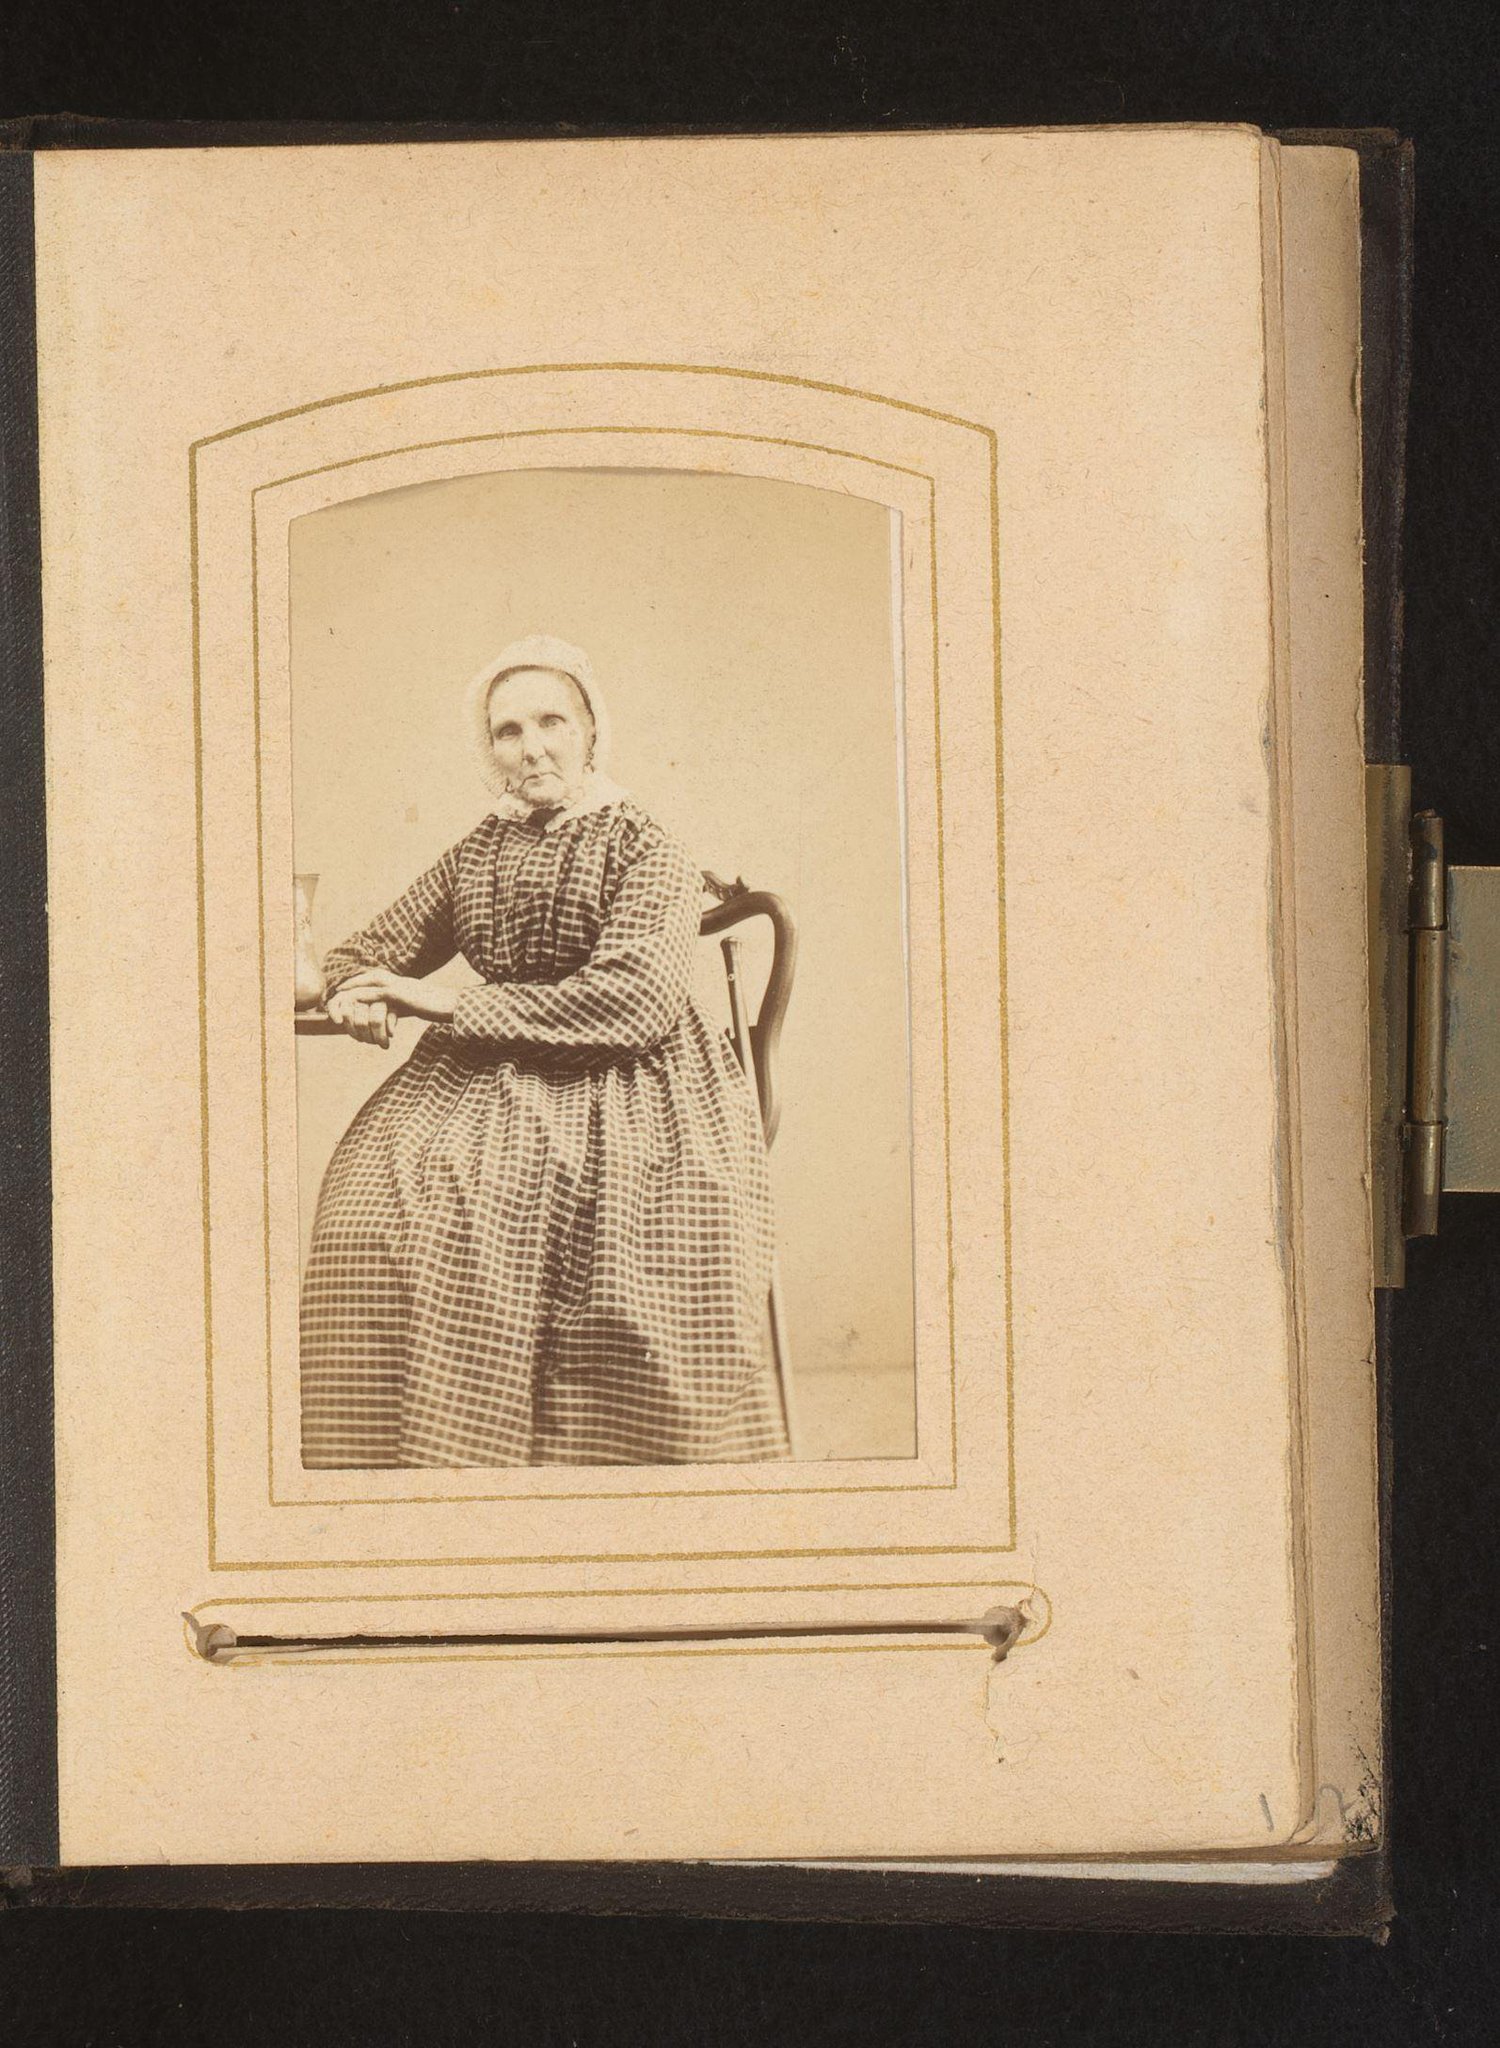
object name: photograph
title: Portret van een zittende oude vrouw met muts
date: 1862-1882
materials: cardboard, photographic support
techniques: albumen print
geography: haarlem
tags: historical persons - bb - woman, old woman, head-gear: cap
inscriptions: inscription: ‘Photographische inrigting/ Ch. Binger & Co./ Zijlstraat No 759/ te Haarlem’